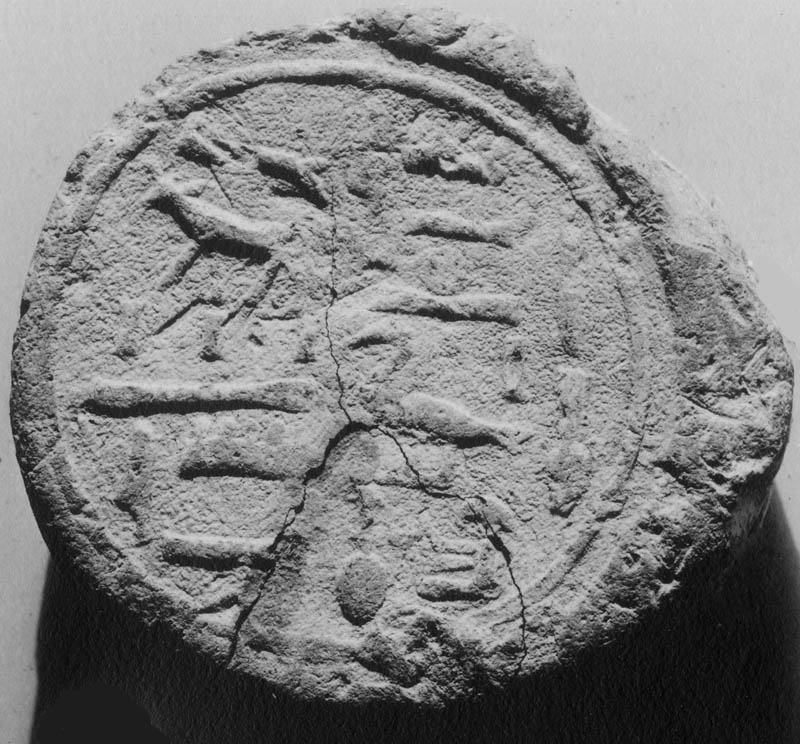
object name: cone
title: Funerary Cone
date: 1550-1295 BCE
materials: pottery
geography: egypt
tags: hieroglyphs